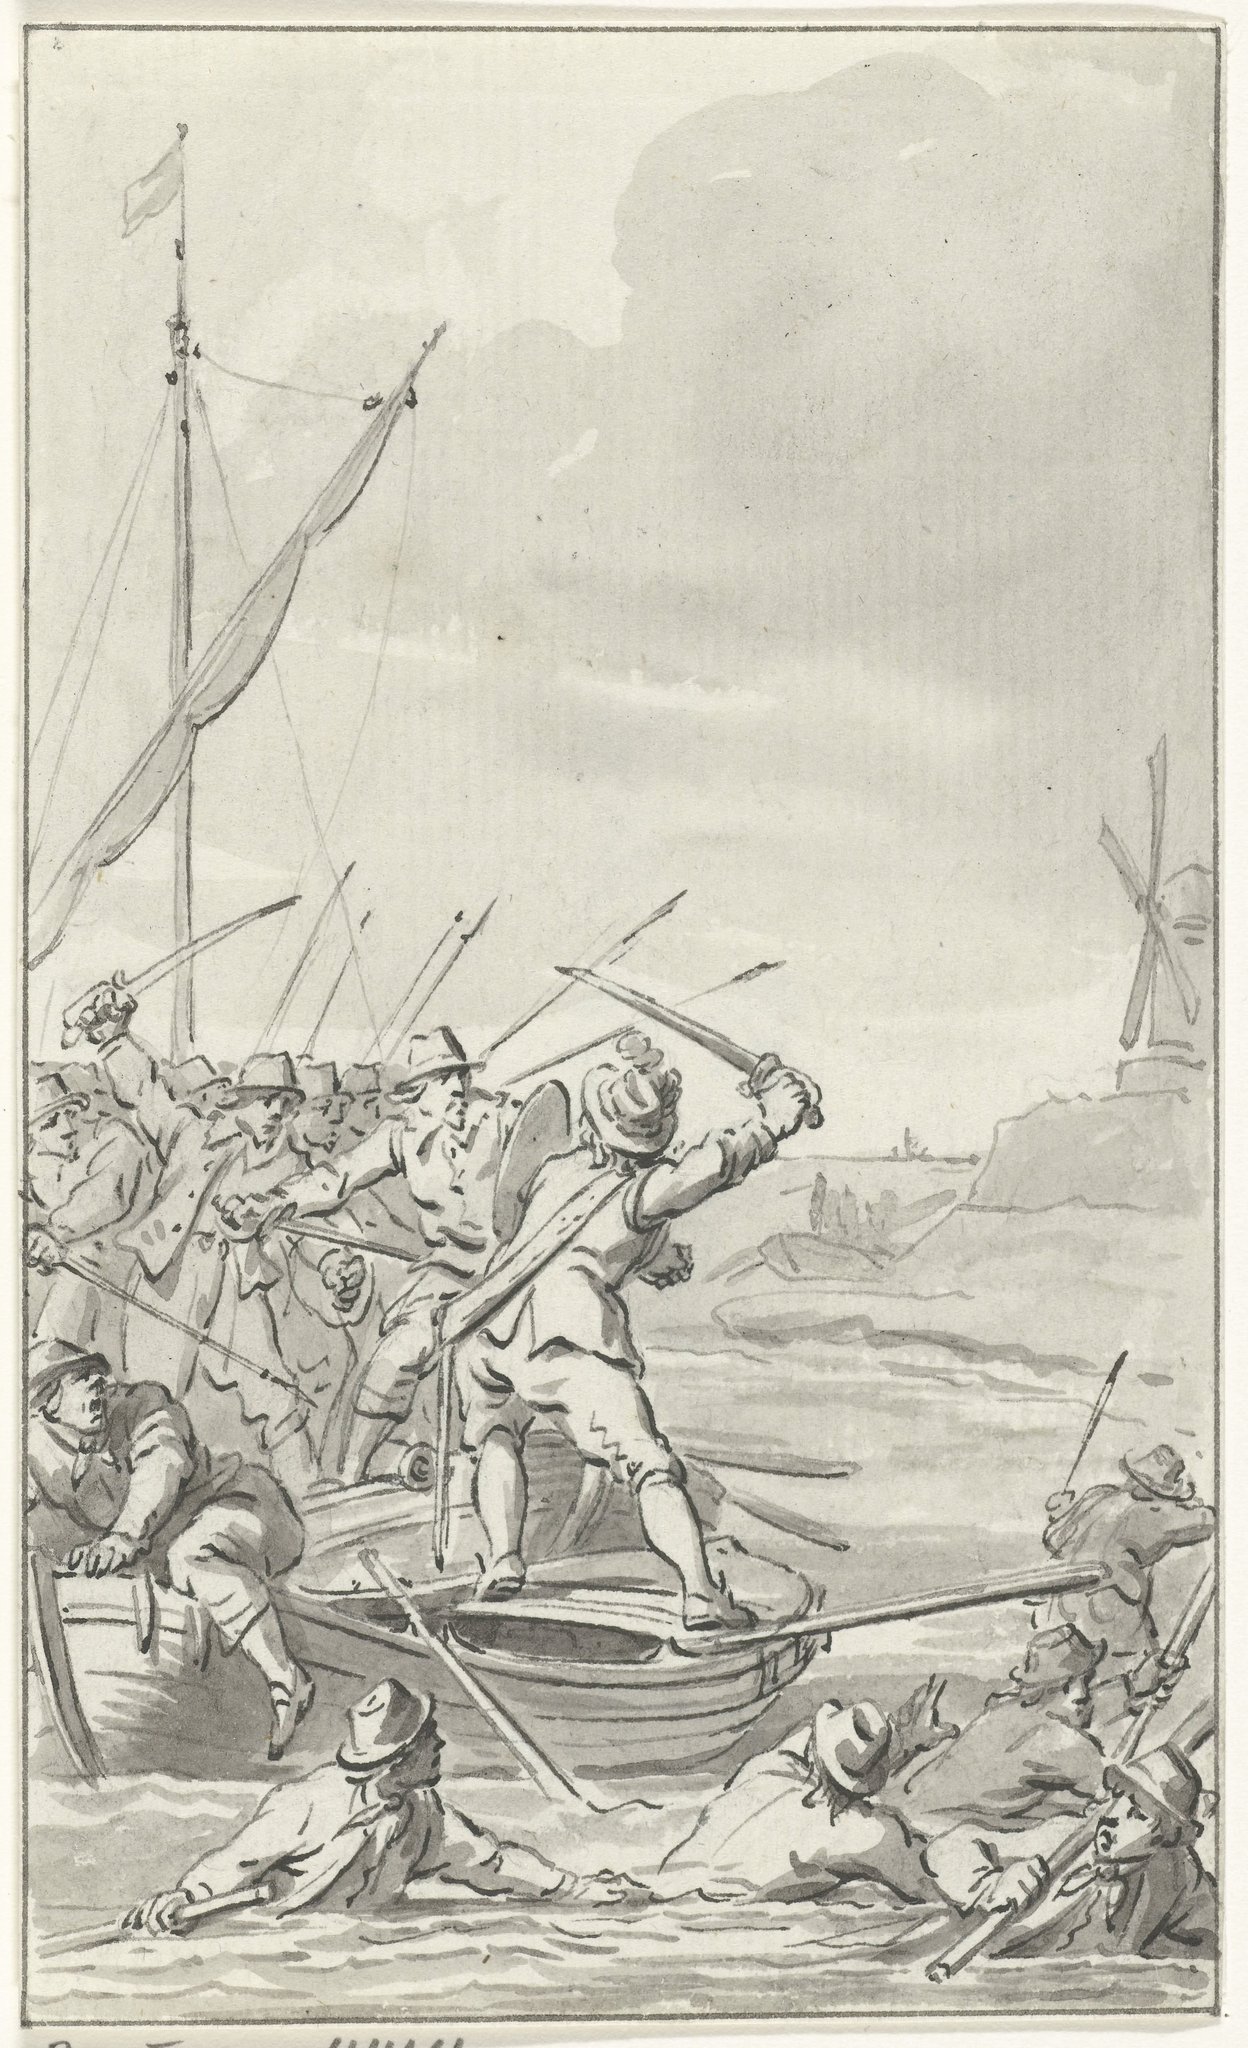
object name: historieplaat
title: Johan van Galen verdedigt zich tegen 20 rovers, 1649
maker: jacobus buys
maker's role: draughtsman, print maker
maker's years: 1724-1801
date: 1783-1799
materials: ink, paper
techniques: brush, pen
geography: northern netherlands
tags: essen, battle (+ naval force), traveller(s) attacked by robber(s)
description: Johan van Galen alleen varend door de Middellandse Zee naar Port Maria, verdedigt zich tegen 20 rovers die hem overvallen, 1649. Ontwerp voor een prent.